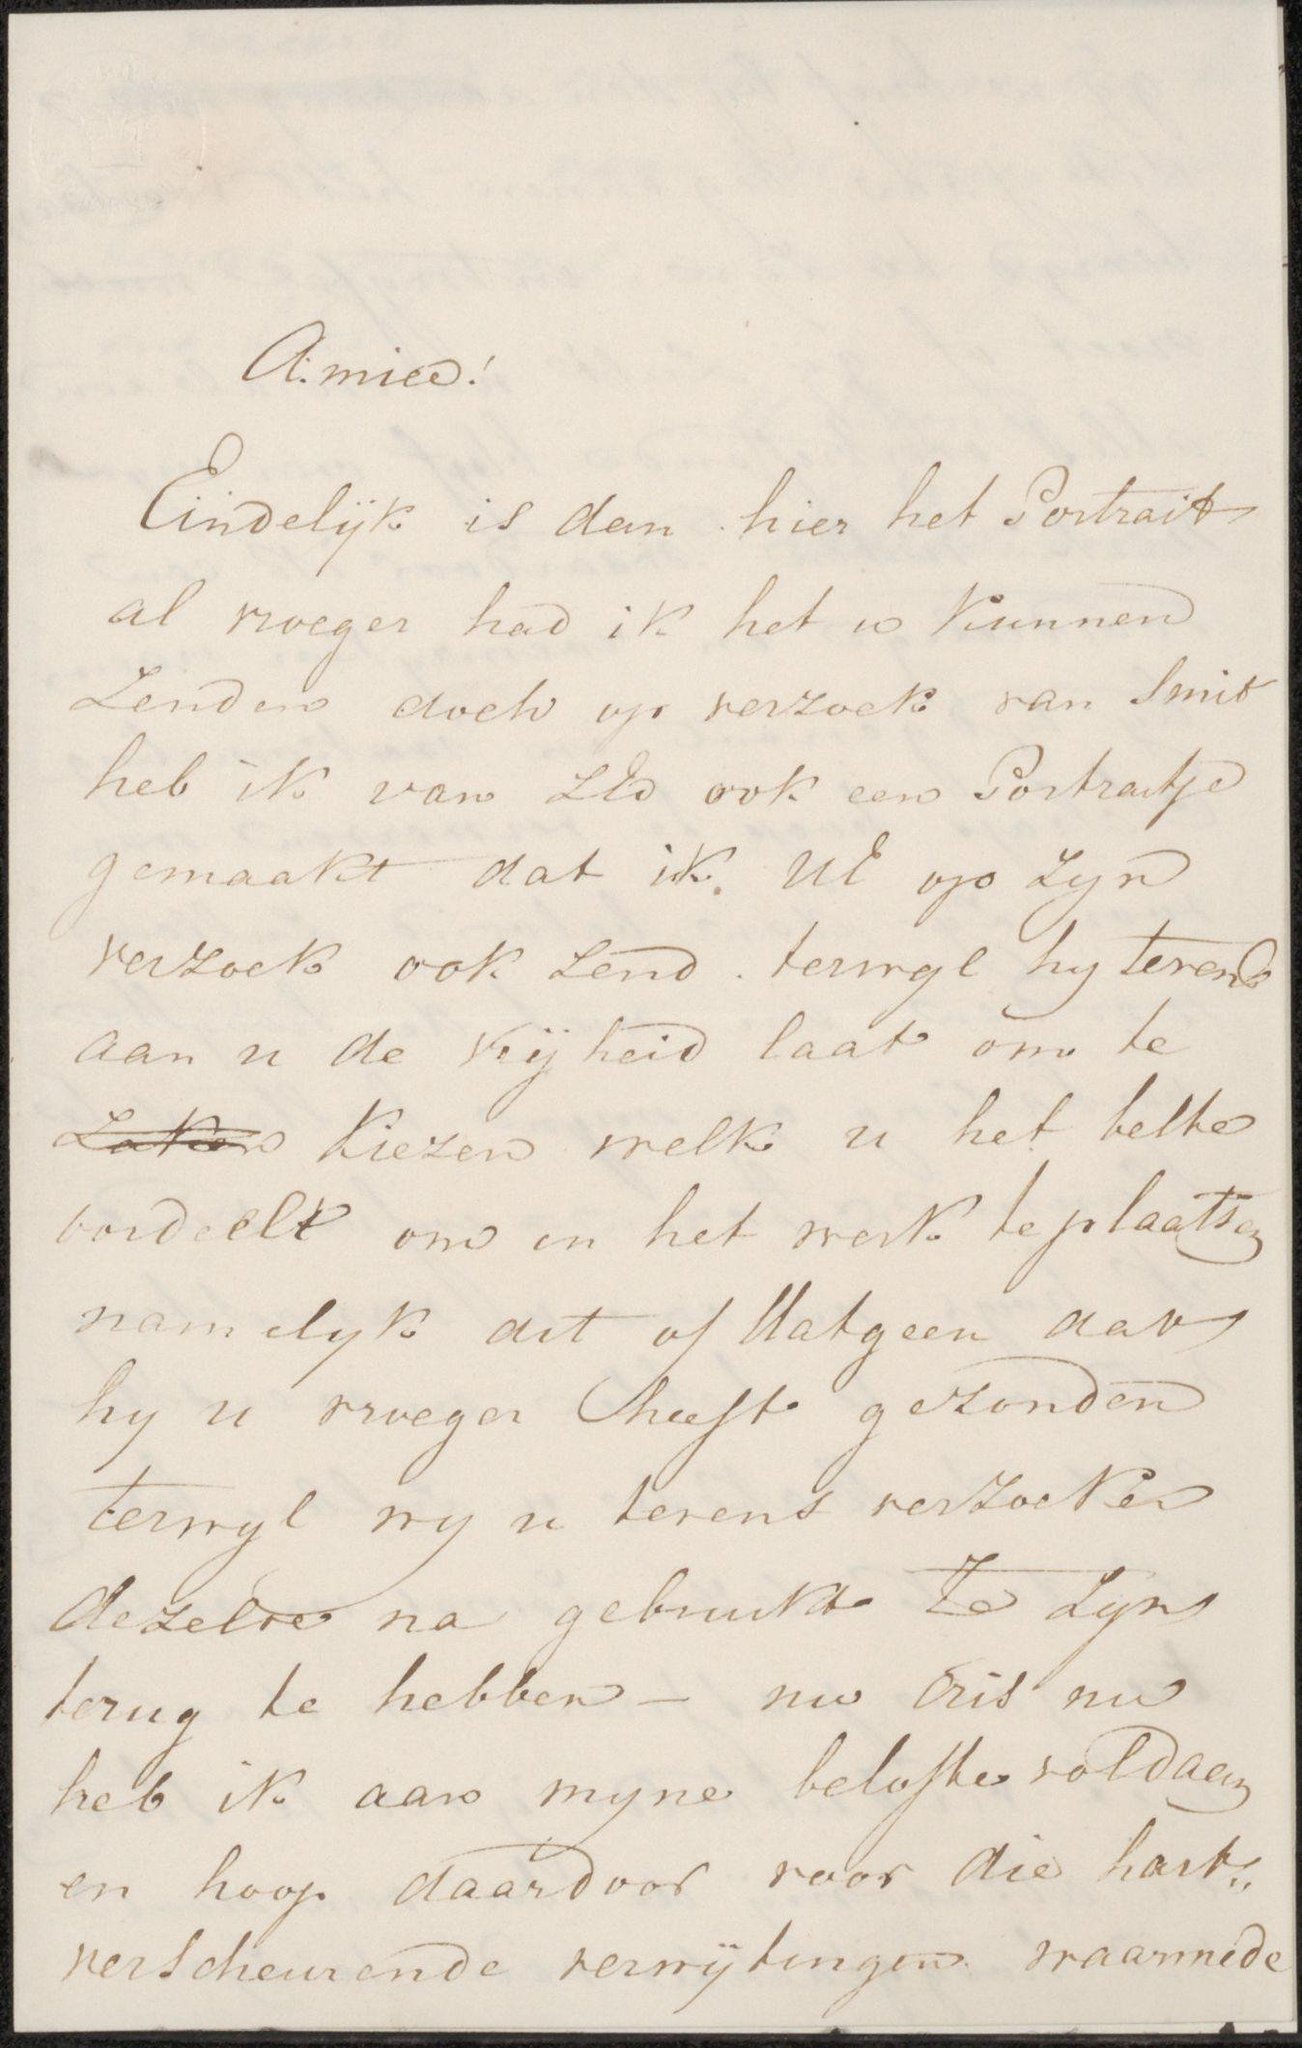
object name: letter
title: Brief aan anoniem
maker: jan hendrik van de laar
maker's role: draughtsman, print maker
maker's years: 1807-1874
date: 1817-1874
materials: ink, paper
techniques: pen, writing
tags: anonymous historical person portrayed, antwerp